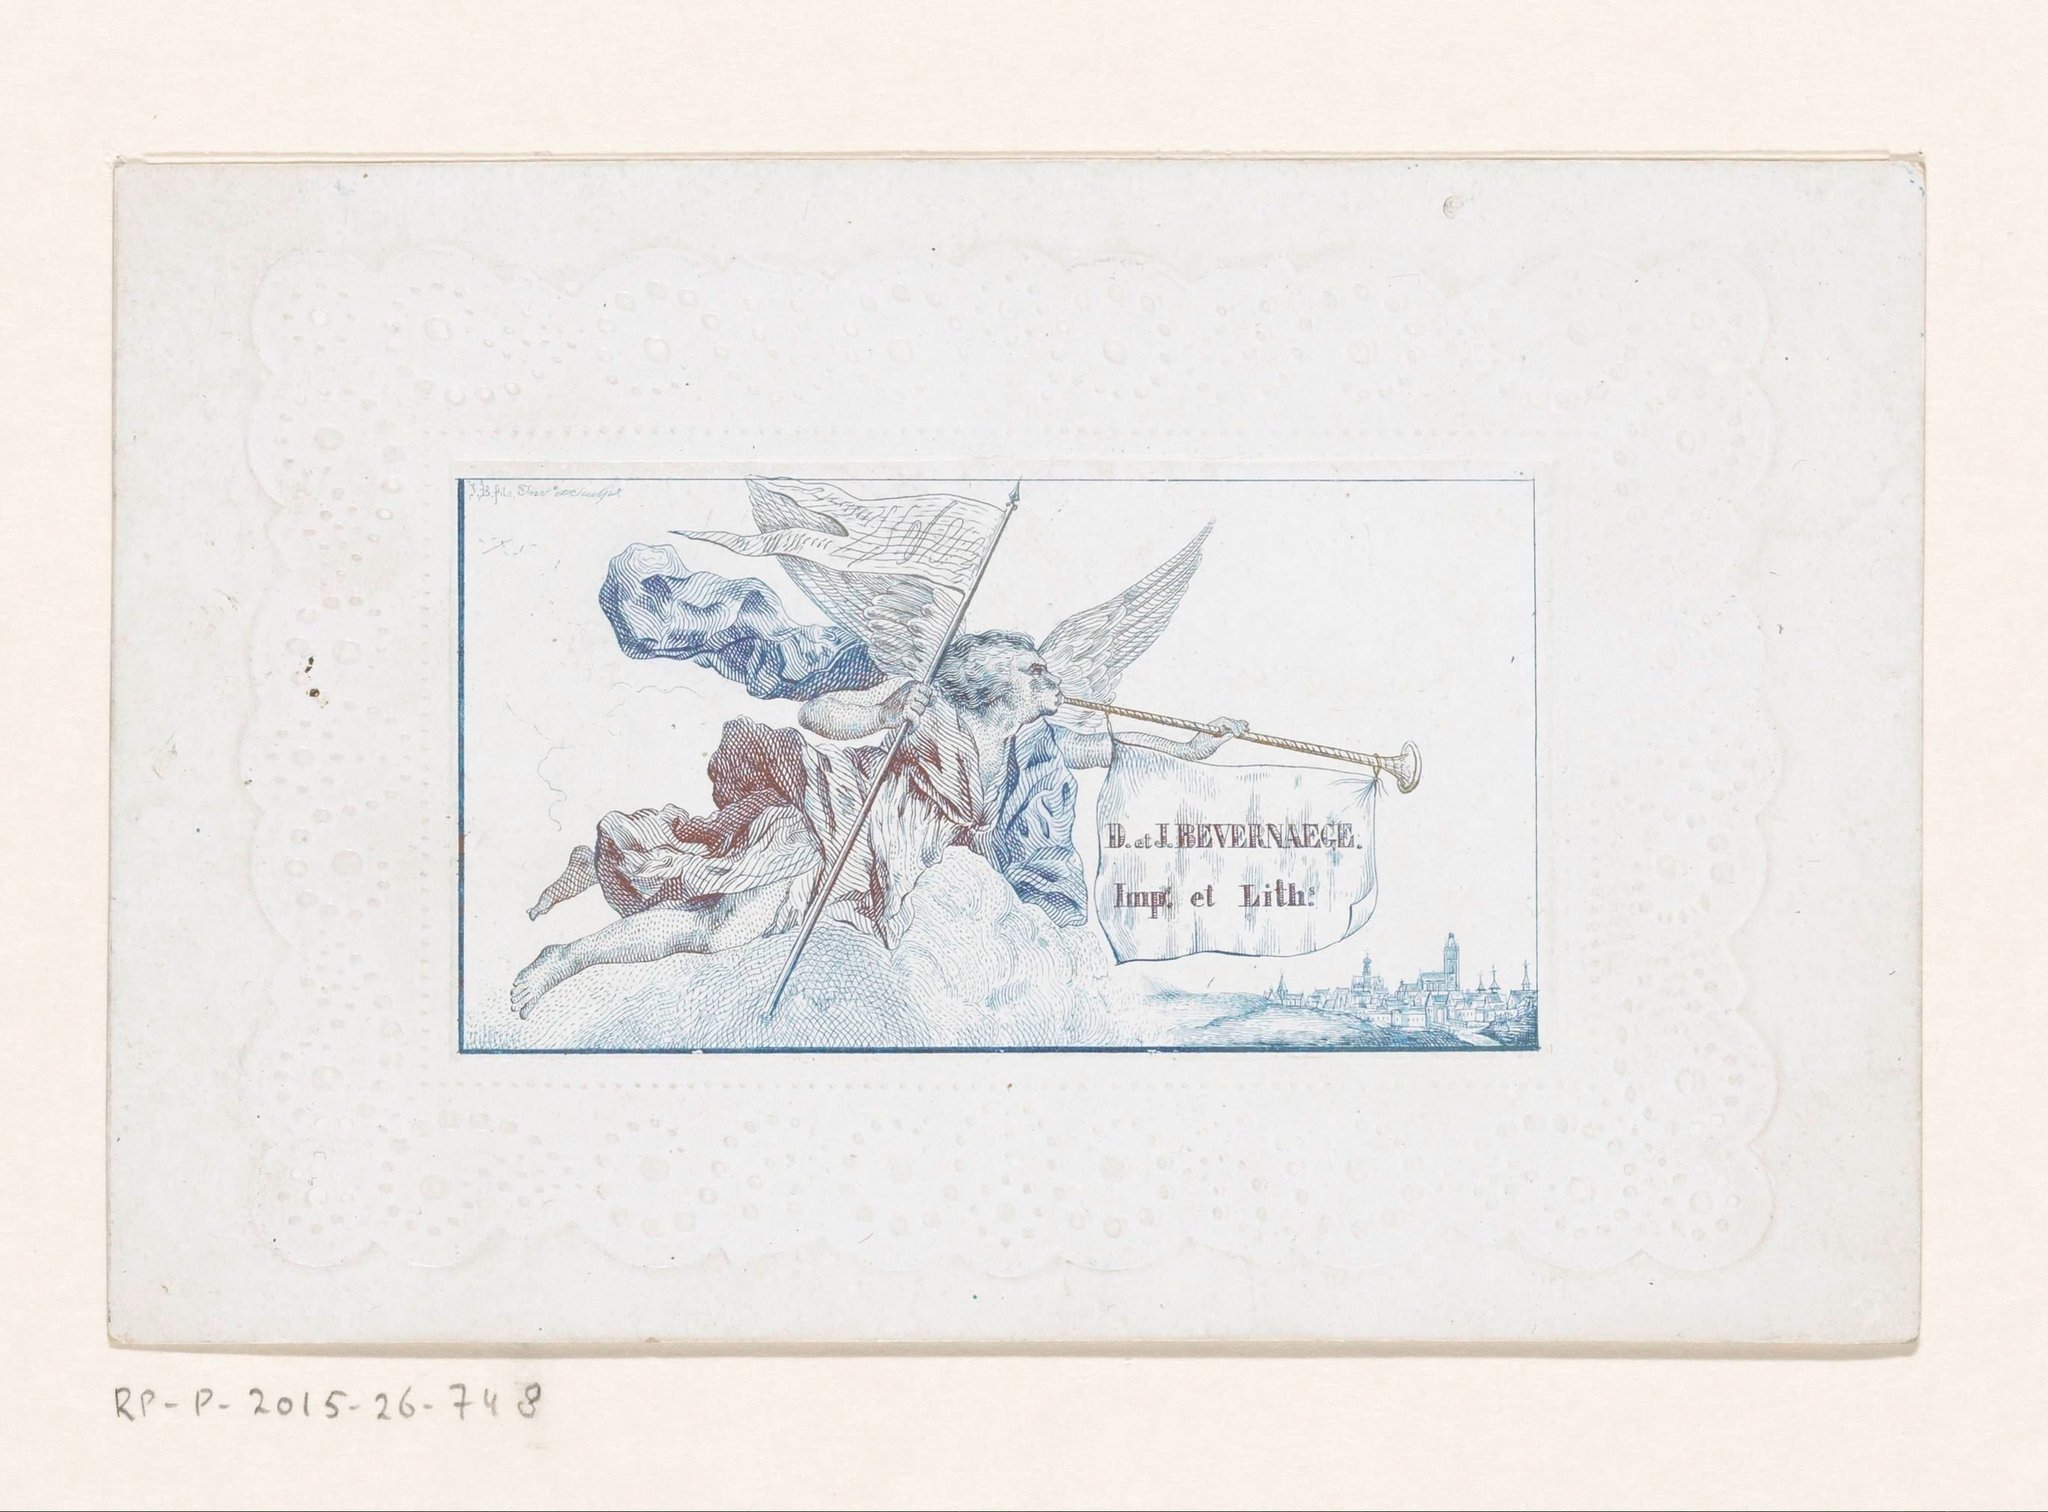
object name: visiting card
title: Visitekaartje van lithografische drukkerij D. en J. Bevernaege te Oudenaarde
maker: j. bevernaege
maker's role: print maker, printer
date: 1840-1875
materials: porcelainized cardboard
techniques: blind stamped, lithograph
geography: oudenaarde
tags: angels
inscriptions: collector's mark: Lugt 2228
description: Een engel met een vaandel en een loftrompet met daaraan een banier, in de achtergrond een gezicht op de stad Oudenaarde.